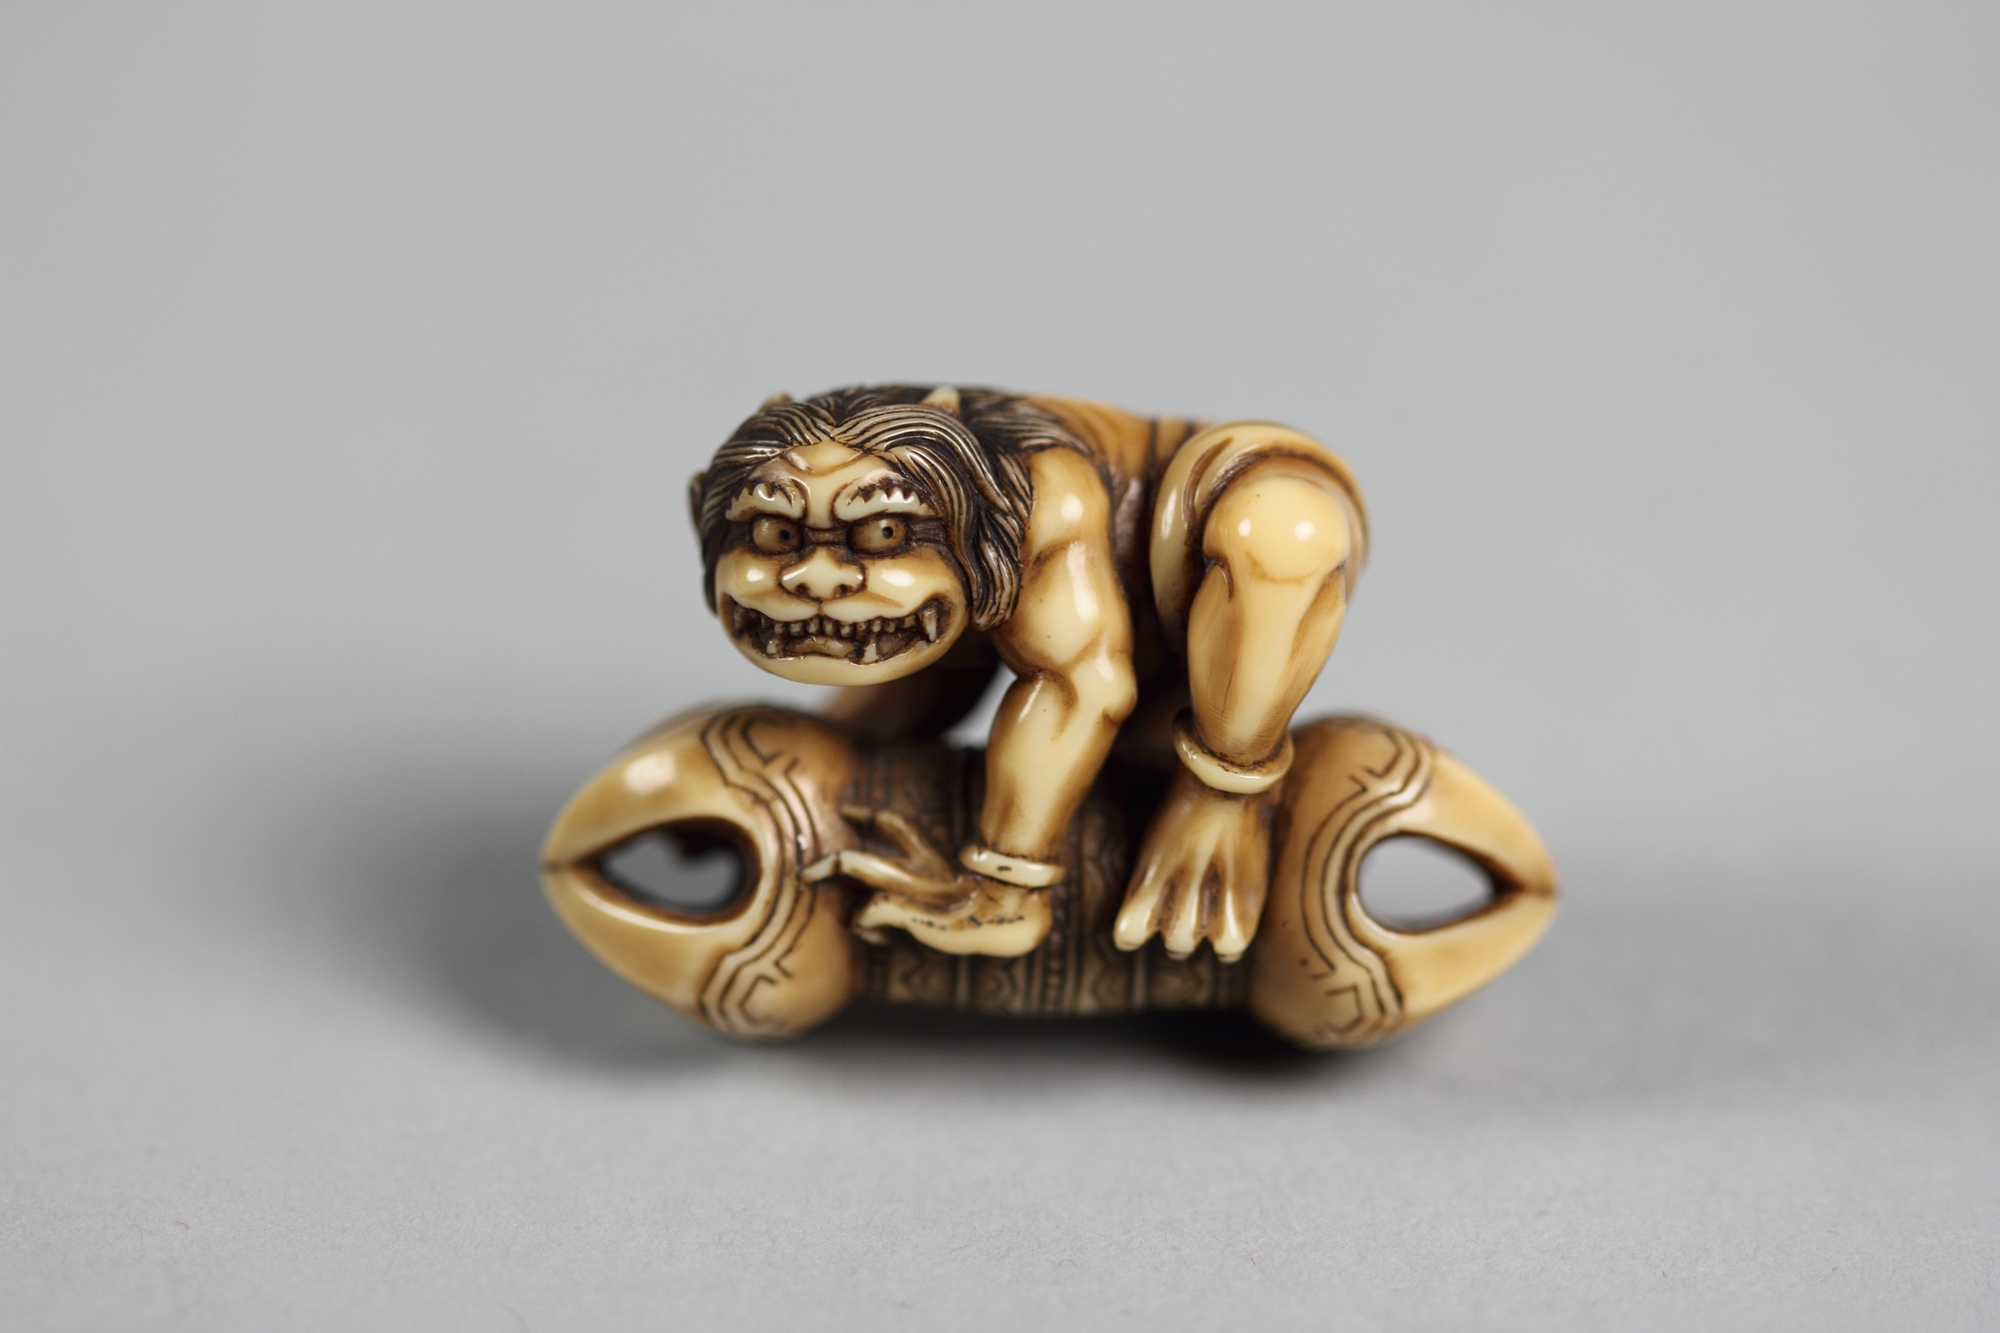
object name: netsuke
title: Netsuke of Ōni on Vadra, Crouching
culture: japanese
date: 1801-1900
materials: ivory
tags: demons